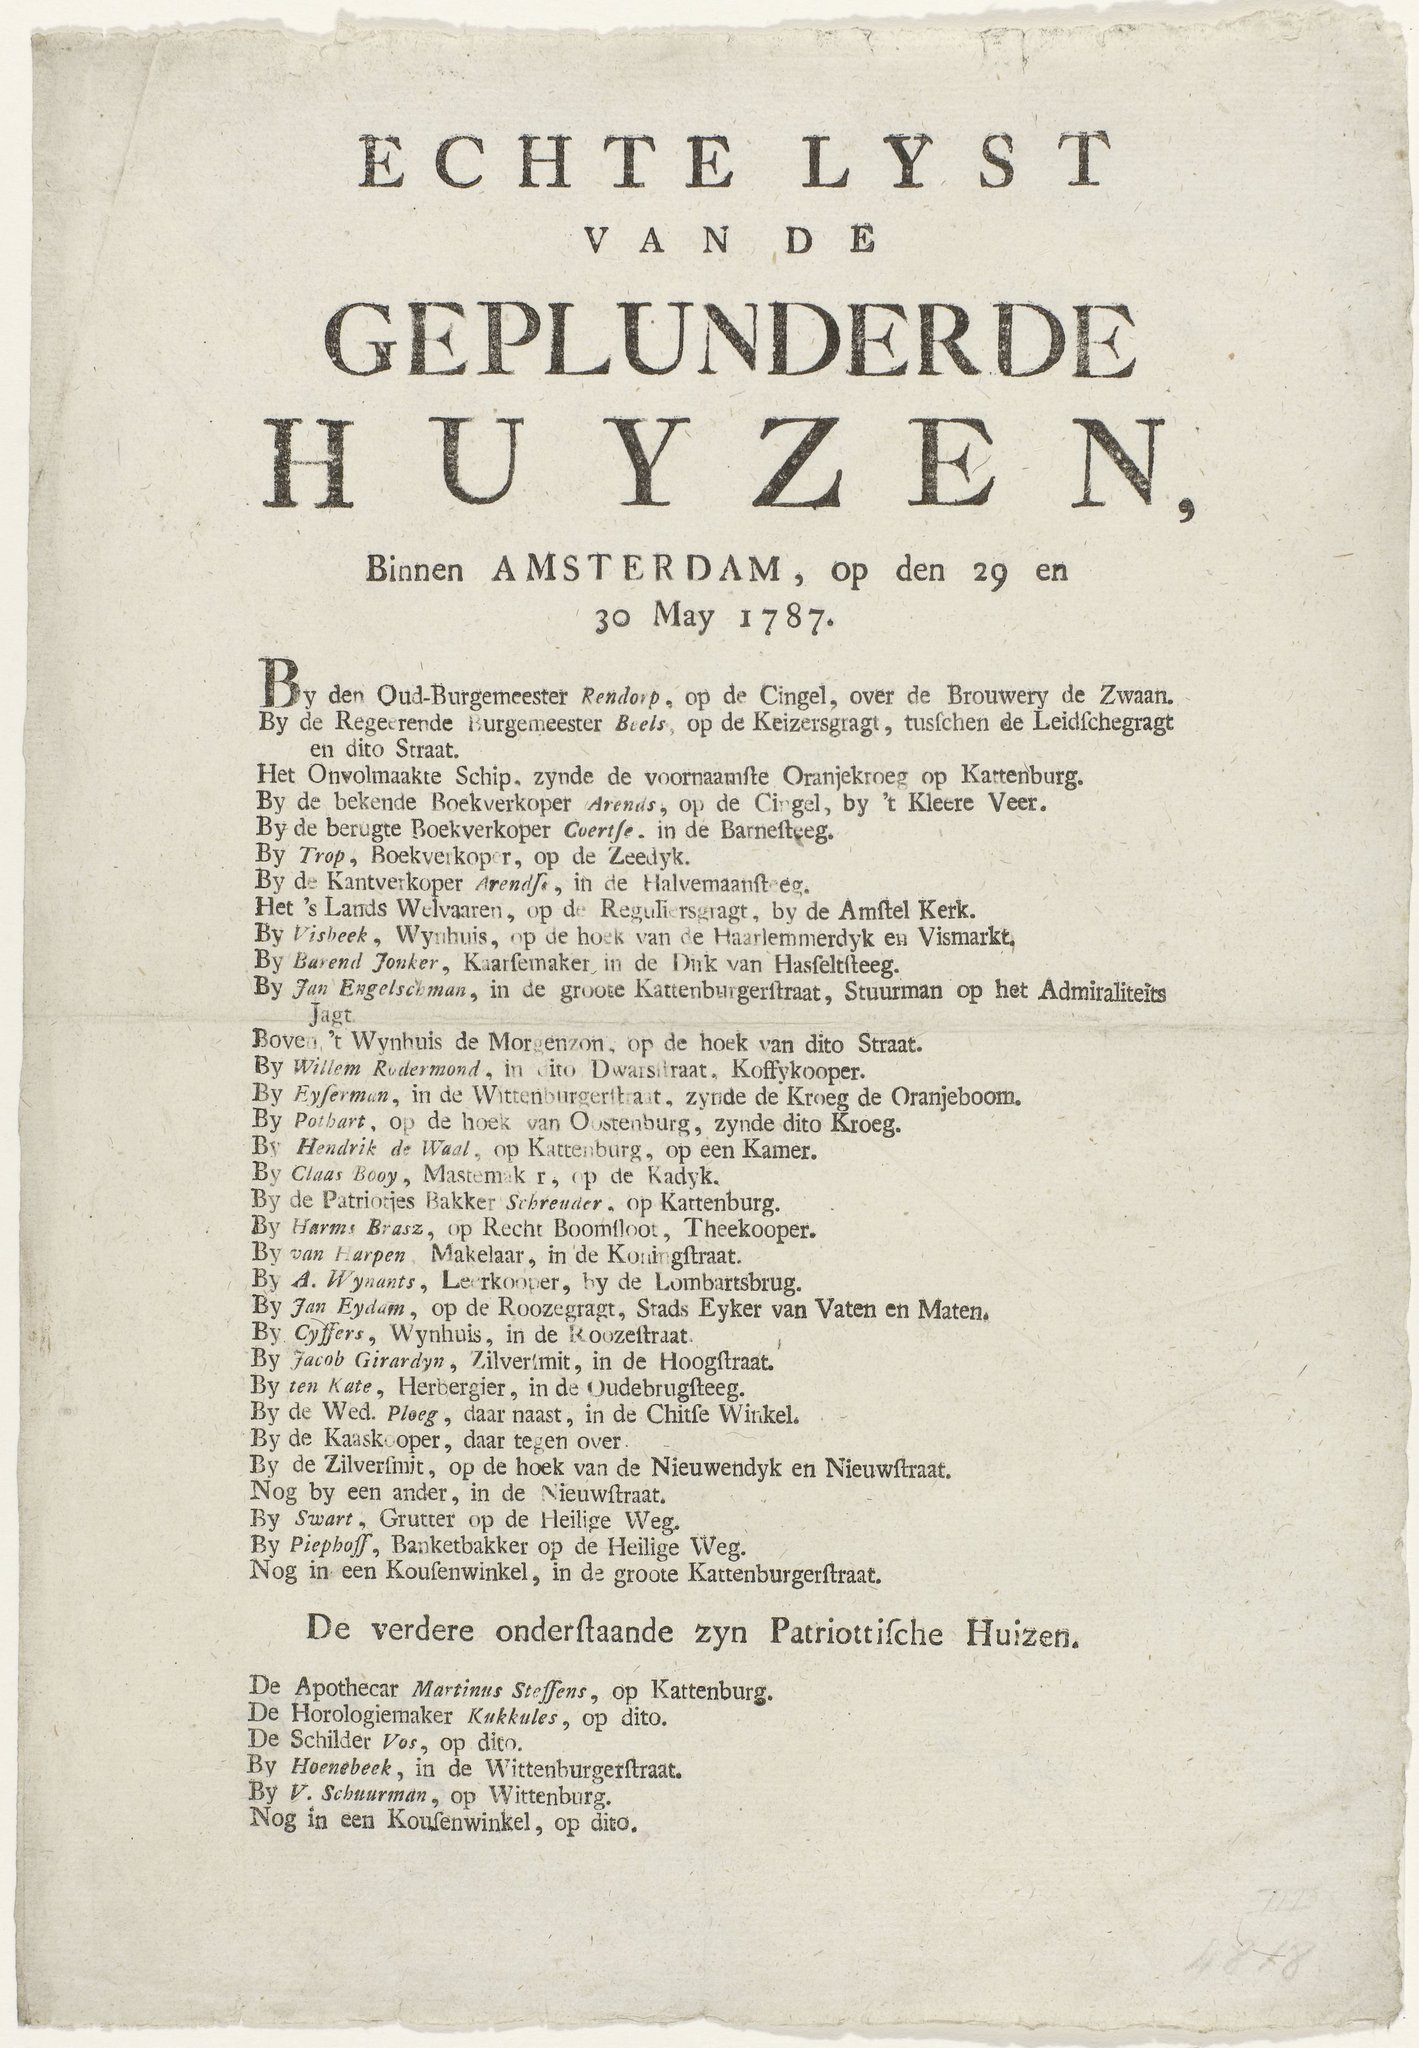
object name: text sheet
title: Lijst van de geplunderde huizen in Amsterdam, 1787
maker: Anonymous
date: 1787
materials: paper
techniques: letterpress printing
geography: northern netherlands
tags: amsterdam, patriots (1780-1795)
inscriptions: collector's mark: Lugt 2228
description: Gedrukte lijst van de huizen van Orangisten, en enkele Patriotten, in Amsterdam geplunderd op 29 en 30 mei 1787.